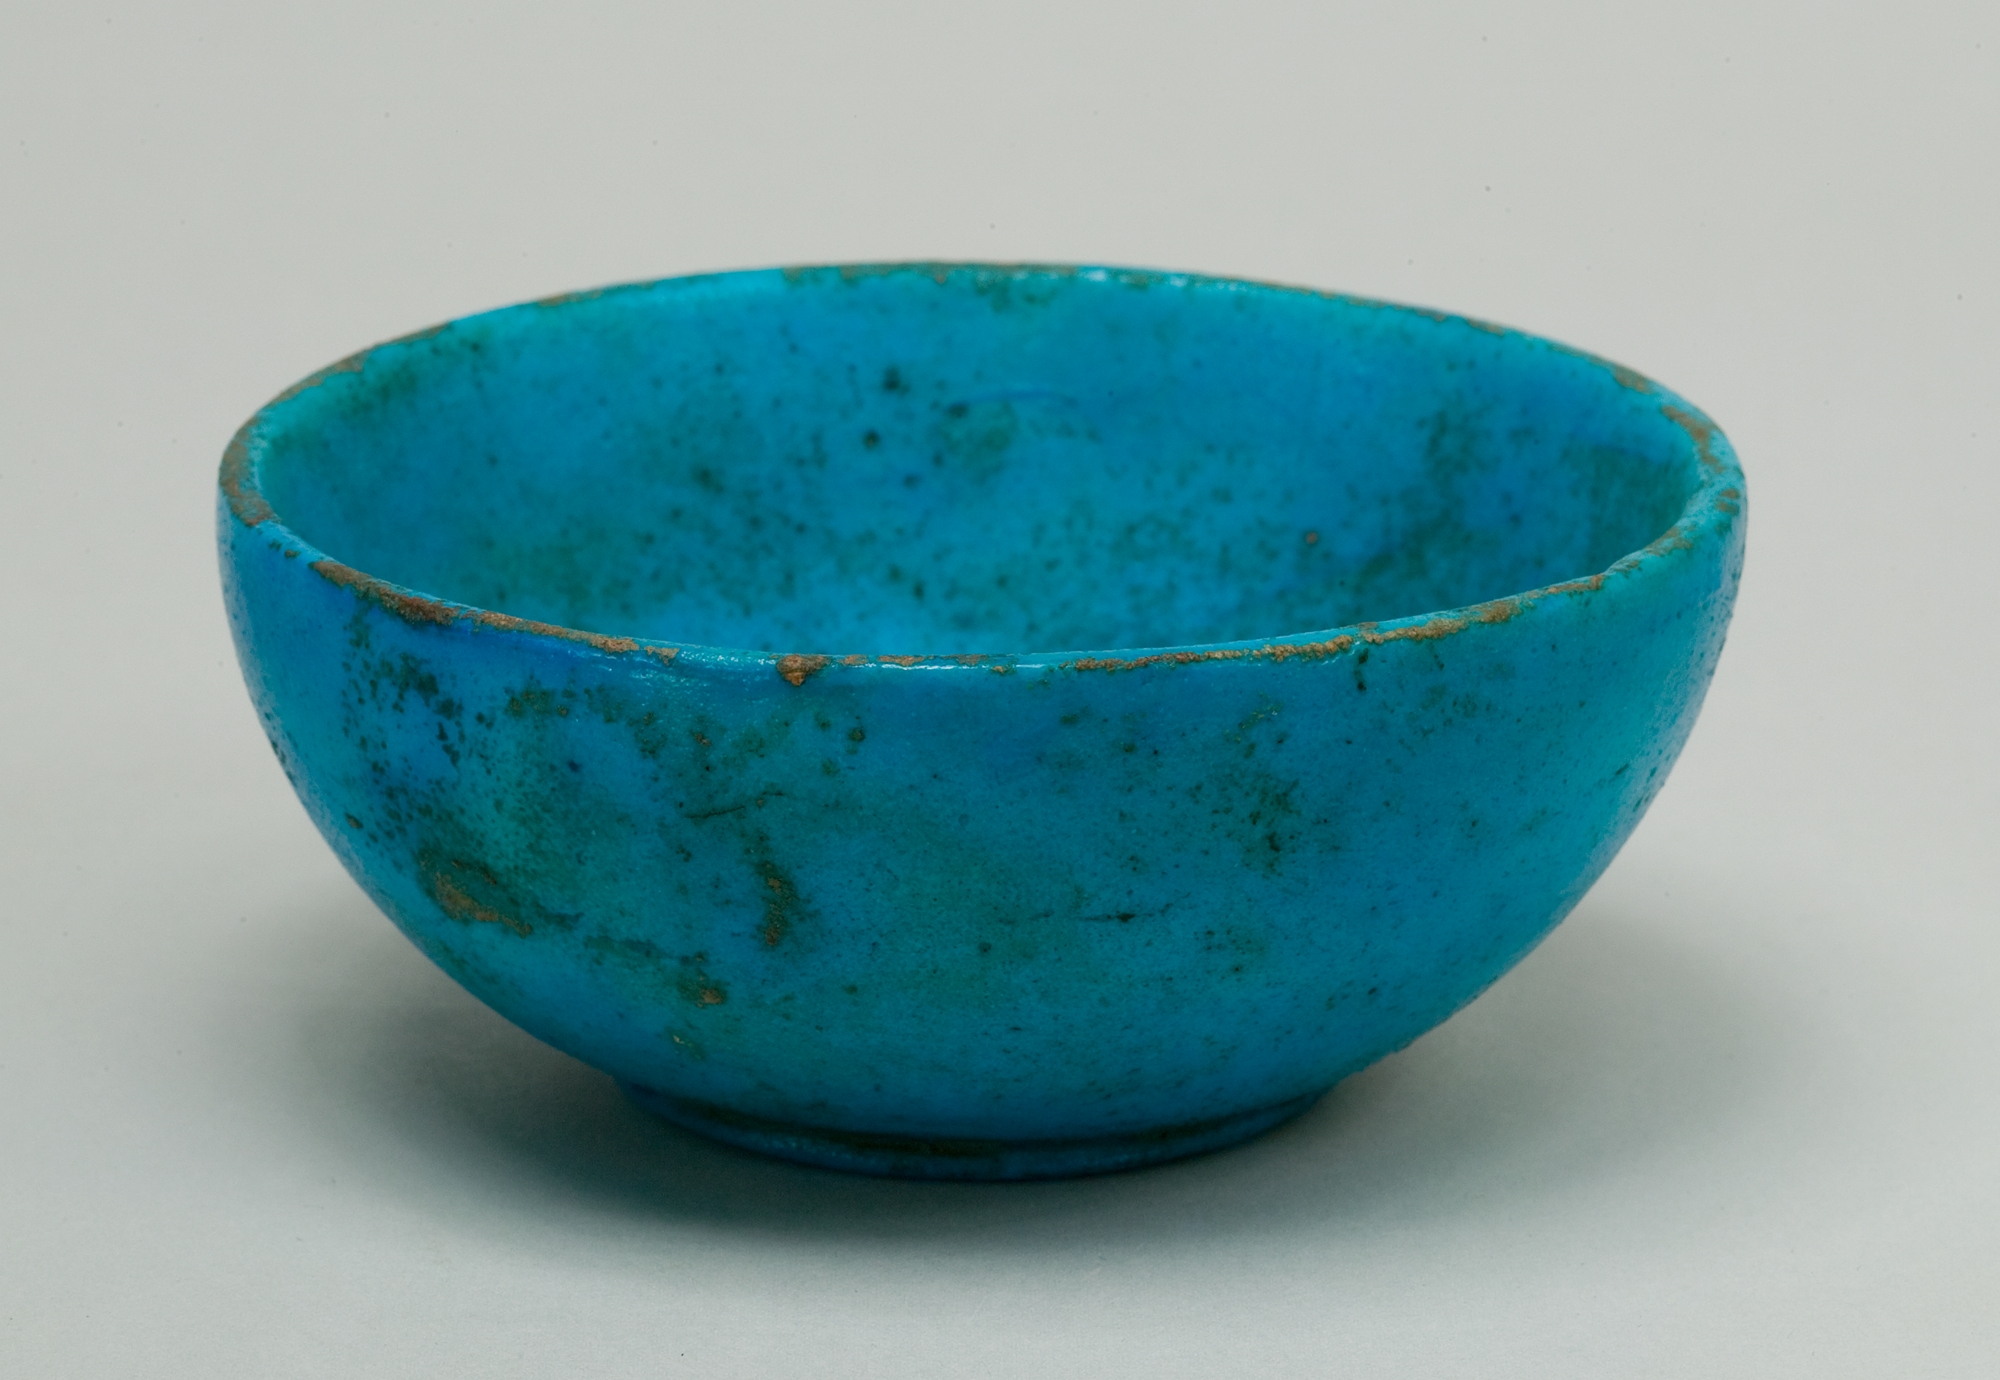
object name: bowl, undecorated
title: Bowl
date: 1635-1458 BCE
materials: faience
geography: egypt